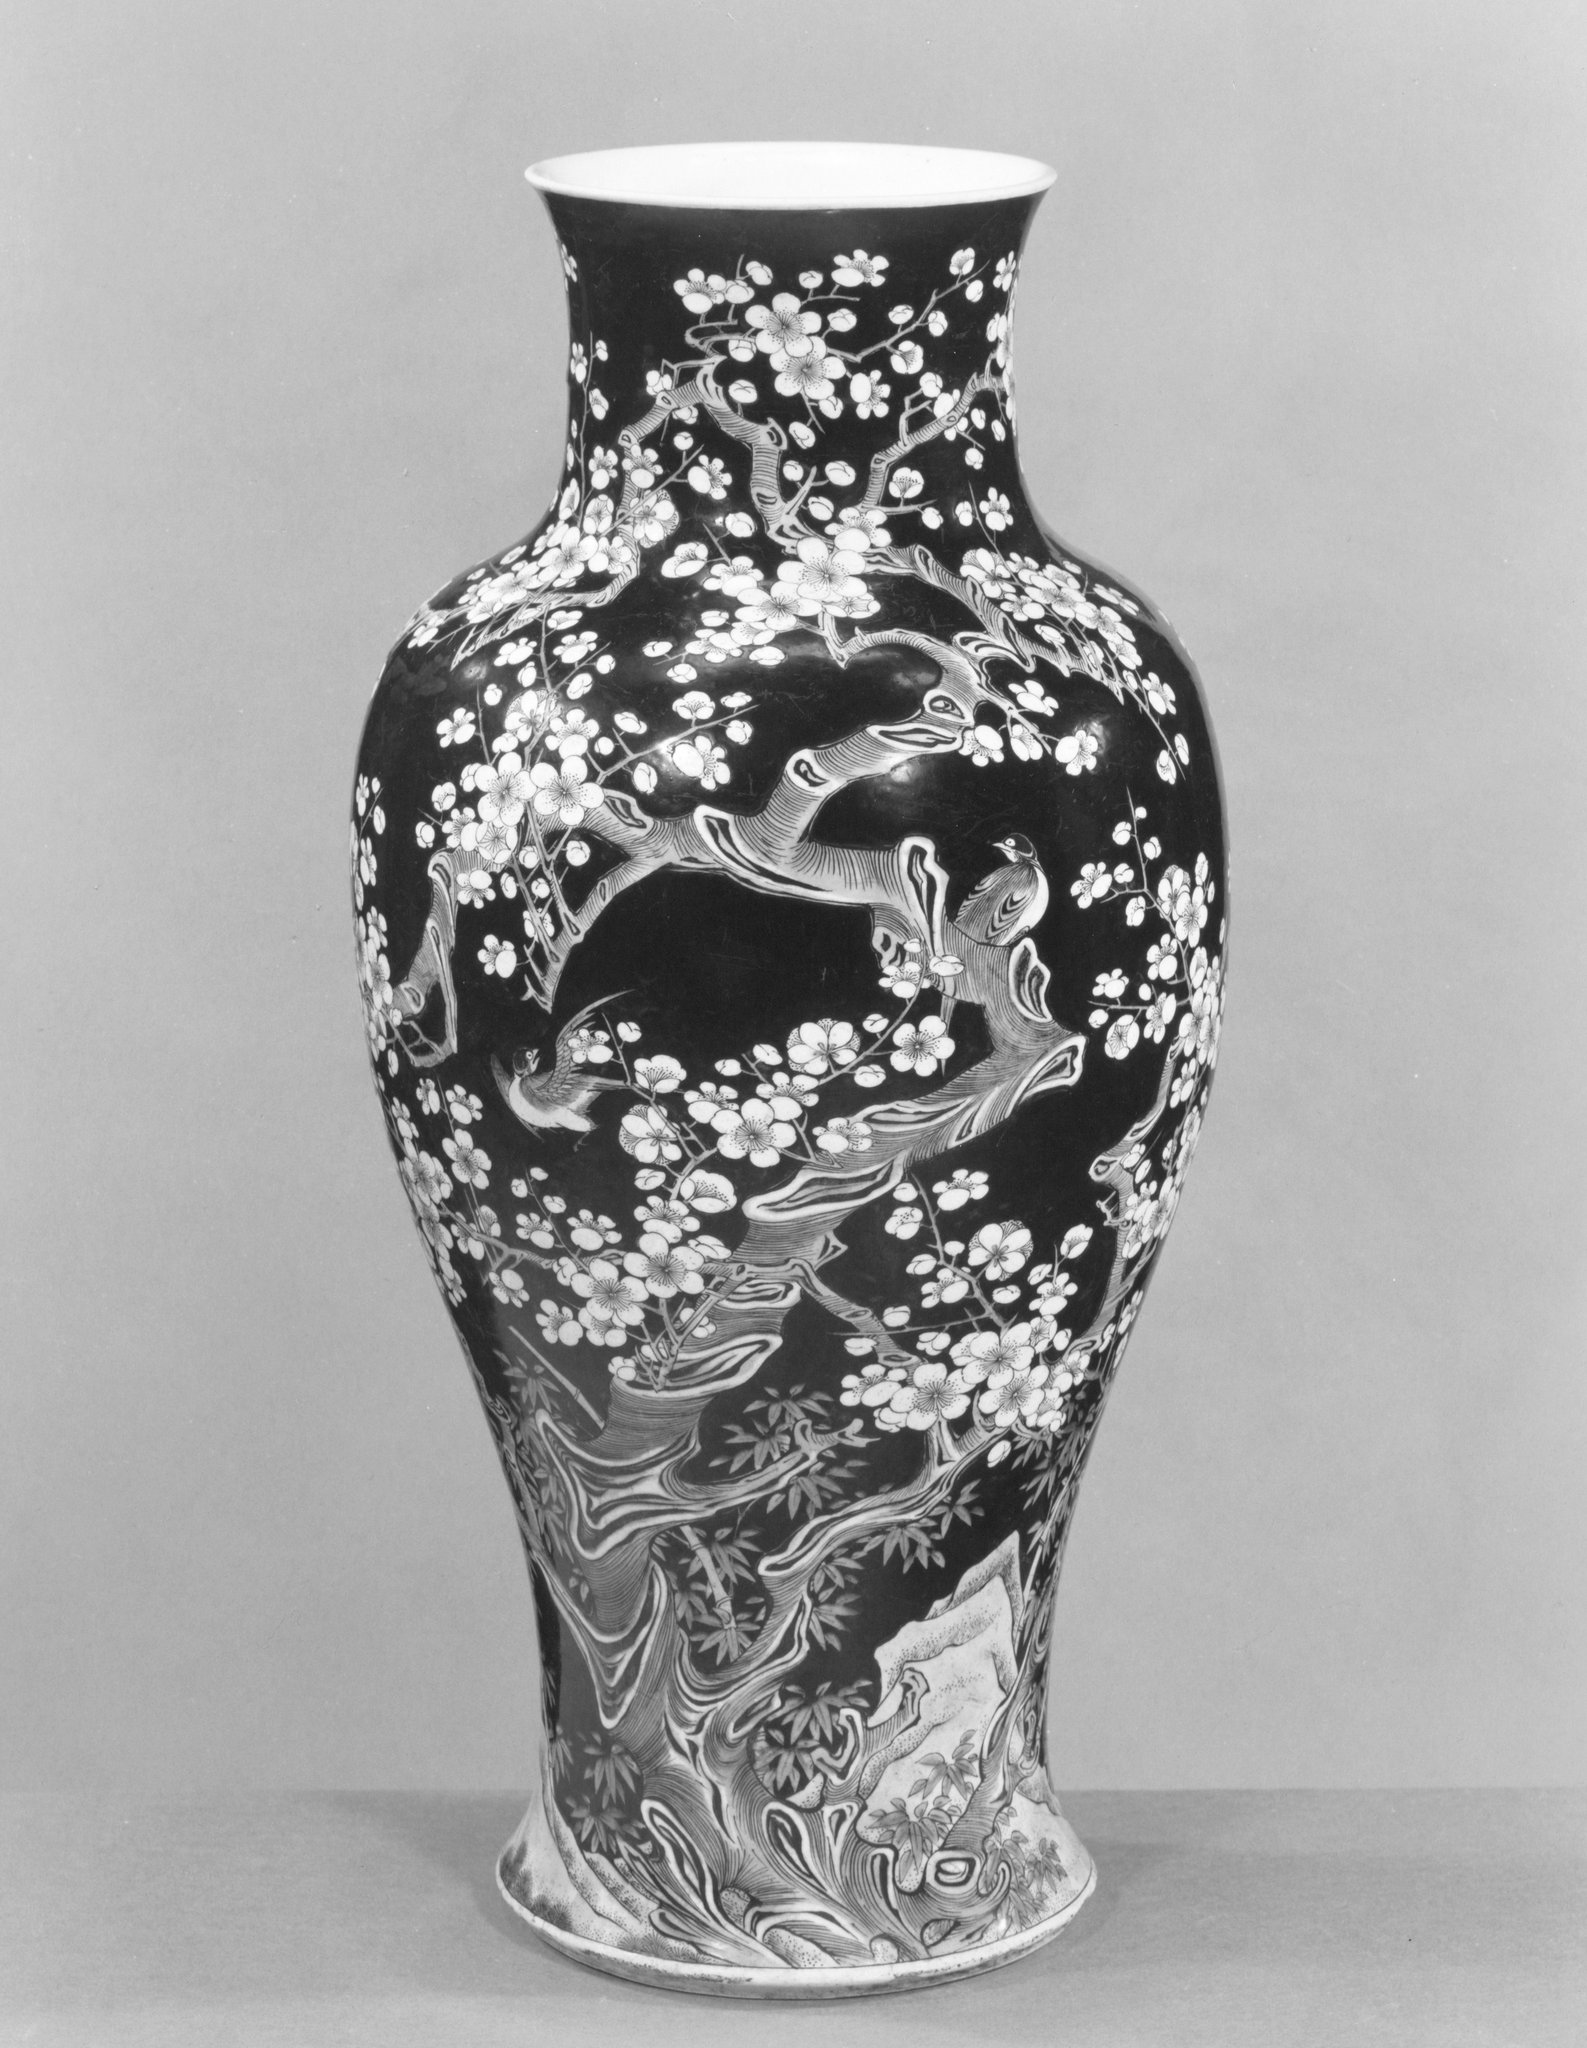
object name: vase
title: Vase with flowers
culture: chinese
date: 1701-1900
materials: enamel, porcelain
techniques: painting, polychrome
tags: flowers,trees